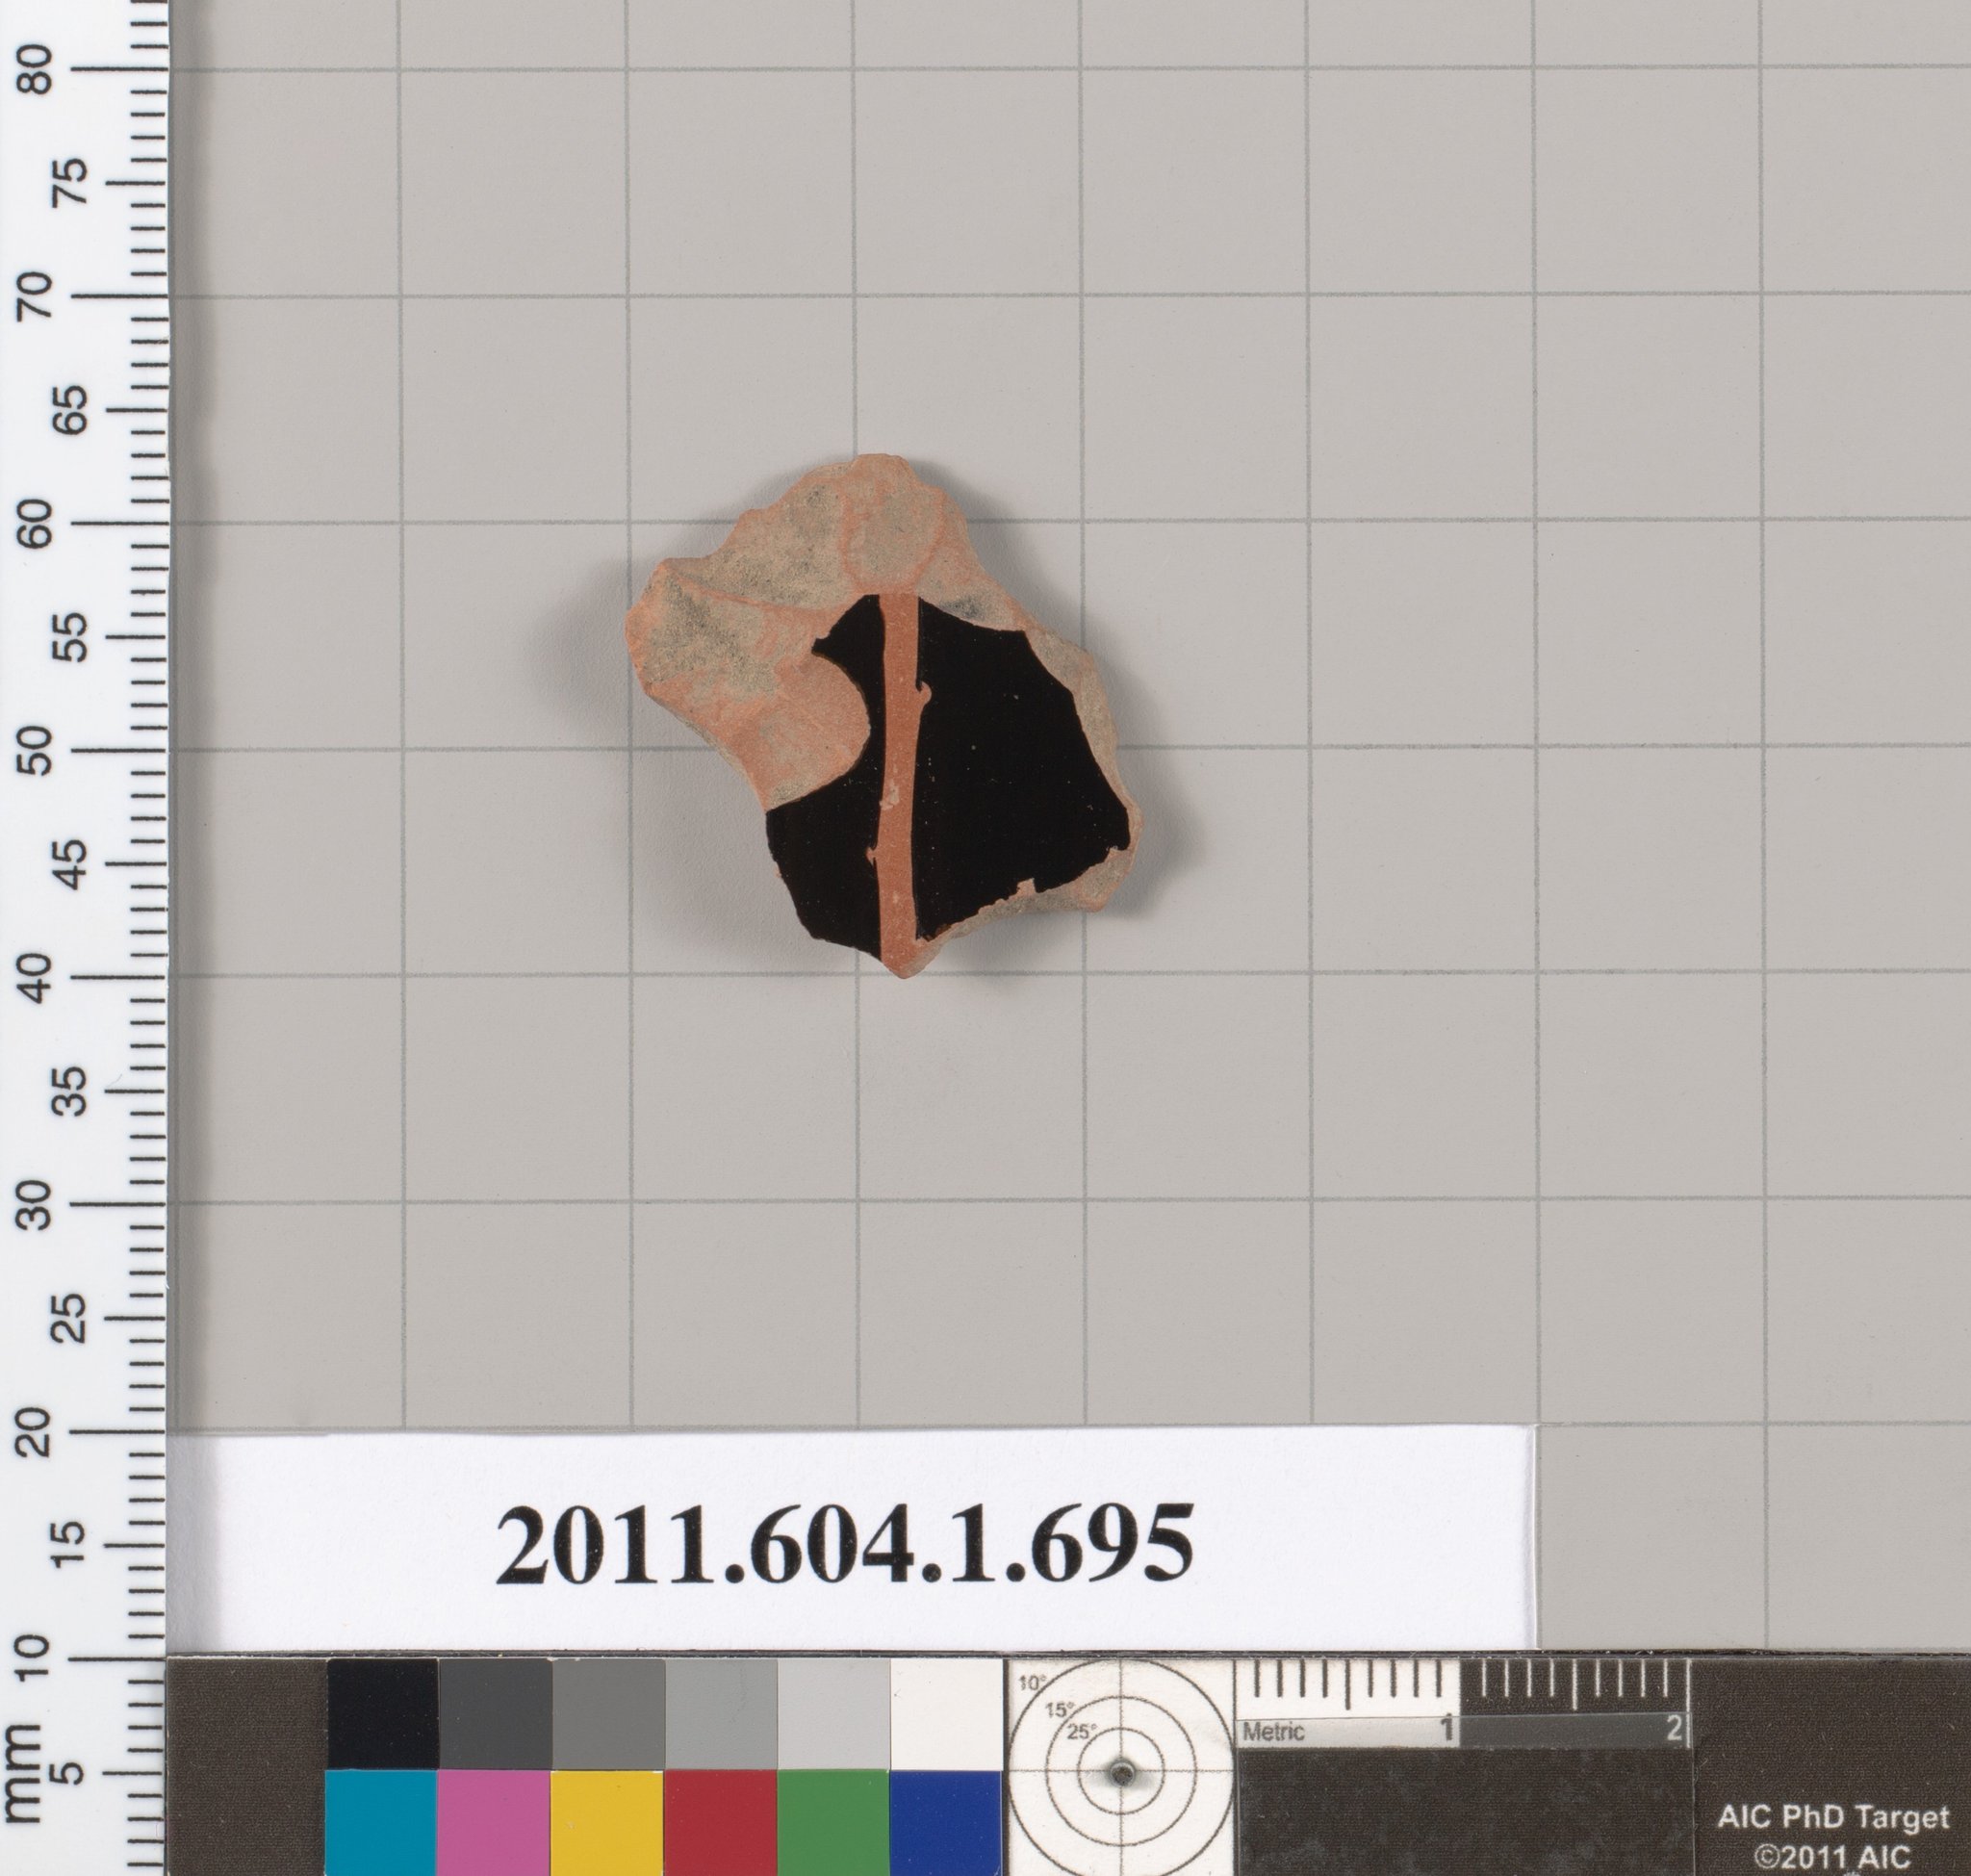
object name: kylix fragment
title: Terracotta fragment of a kylix (drinking cup)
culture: greek, attic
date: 475-451 BCE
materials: terracotta